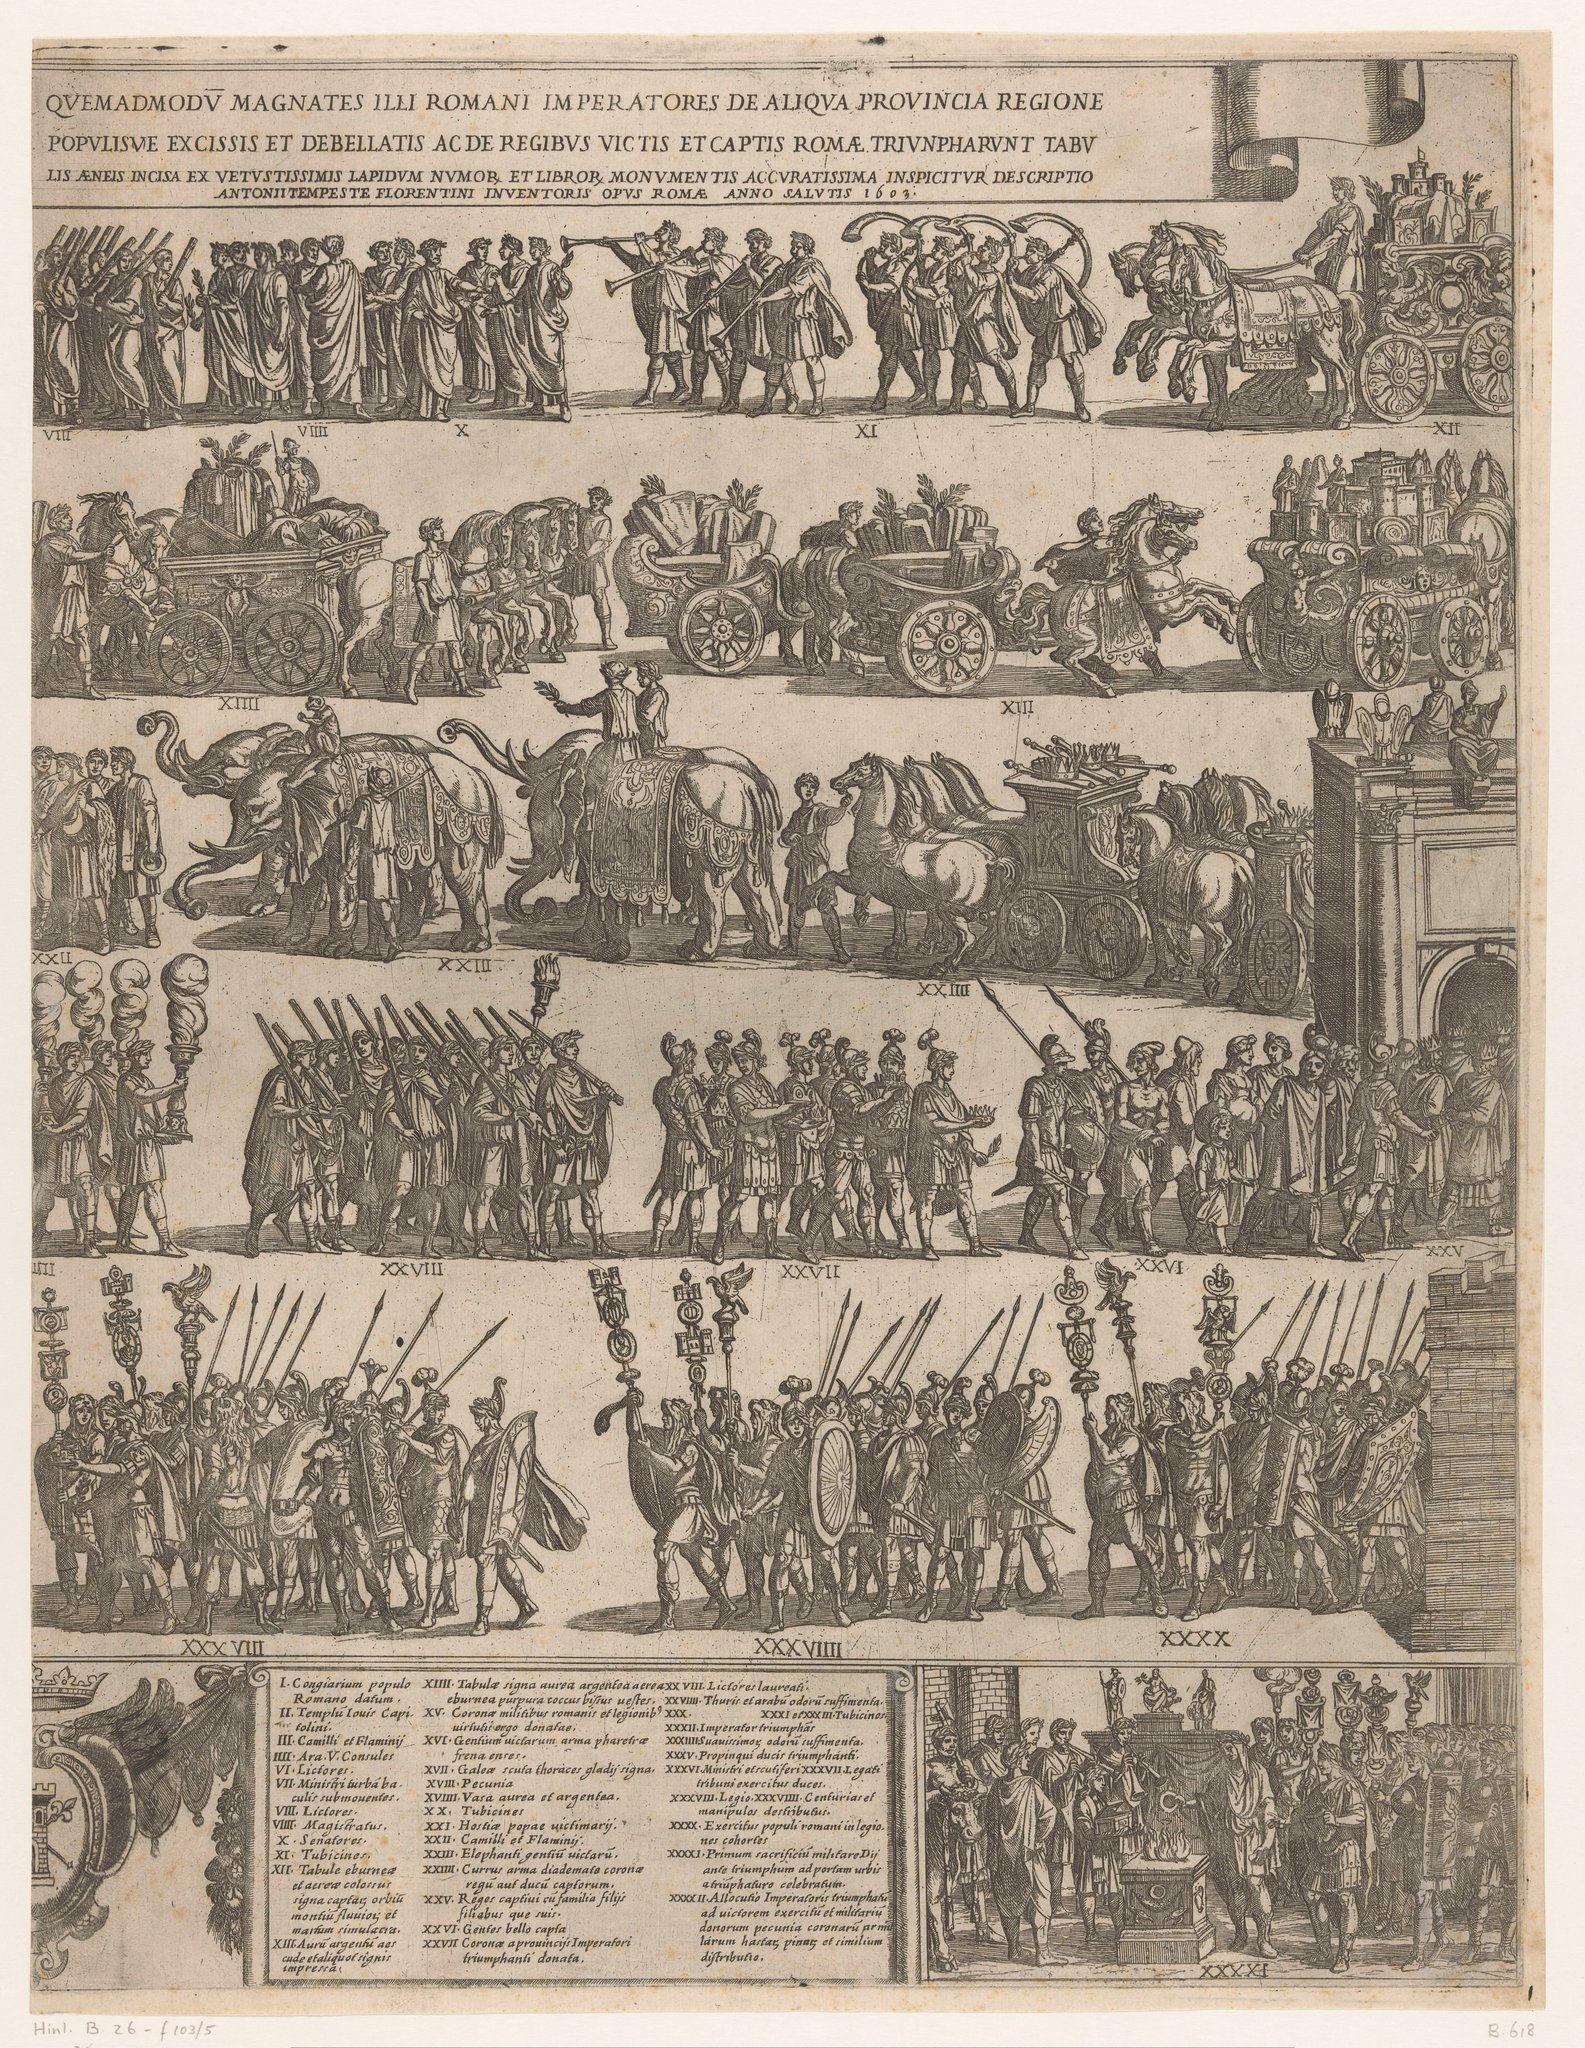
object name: print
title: Triomf van een Romeins keizer (rechter deel)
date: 1603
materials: paper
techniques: etching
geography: italy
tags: triumphal arch, triumphal entry and public reception, pageant, 'entrée solennelle', 'joyeuse entrée', emperor, carrying off the spoils of war, division of the spoils of war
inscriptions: number: ‘1’, collector's mark: Lugt 11, collector's mark: ‘Hinloopen’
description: Een triomftocht van een Romeins keizer. De stoet trekt van rechtsonder, onder twee triomfbogen door, naar een tempel linksboven. De stoet bestaat uit soldaten, gevangenen, olifanten, wagens vol oorlogsbuit en de keizer. Linksonder een voorstelling van de keizer die de oorlogsbuit verdeelt. Rechtsonder een voorstelling van een offerscène en een verklarende lijst met nummers.